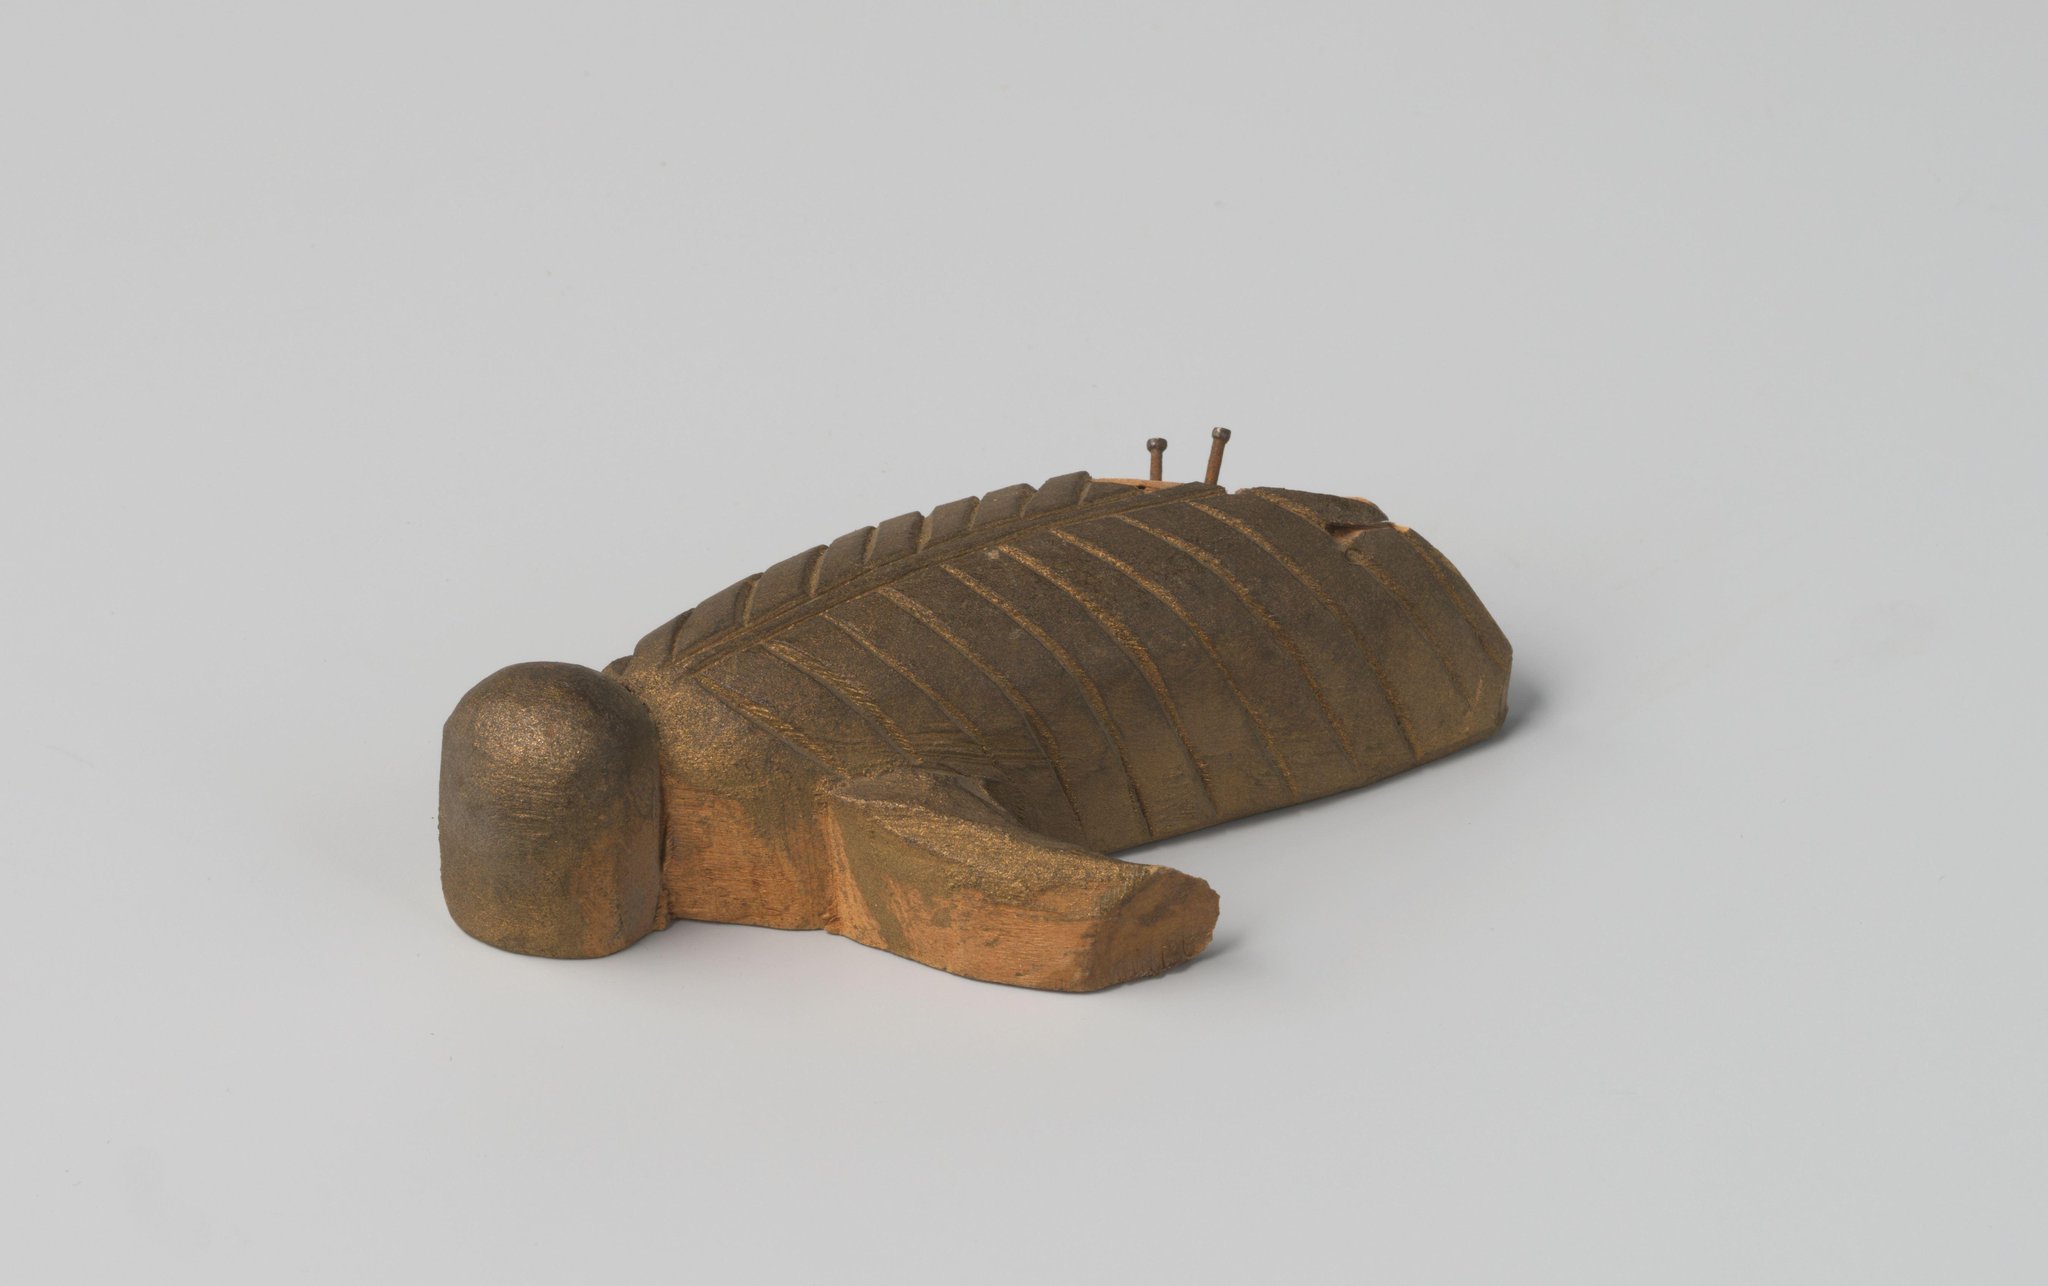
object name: wapenbord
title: Fragment van een wapenbord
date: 1665-1725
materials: wood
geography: netherlands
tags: lambert bernard van rechteren